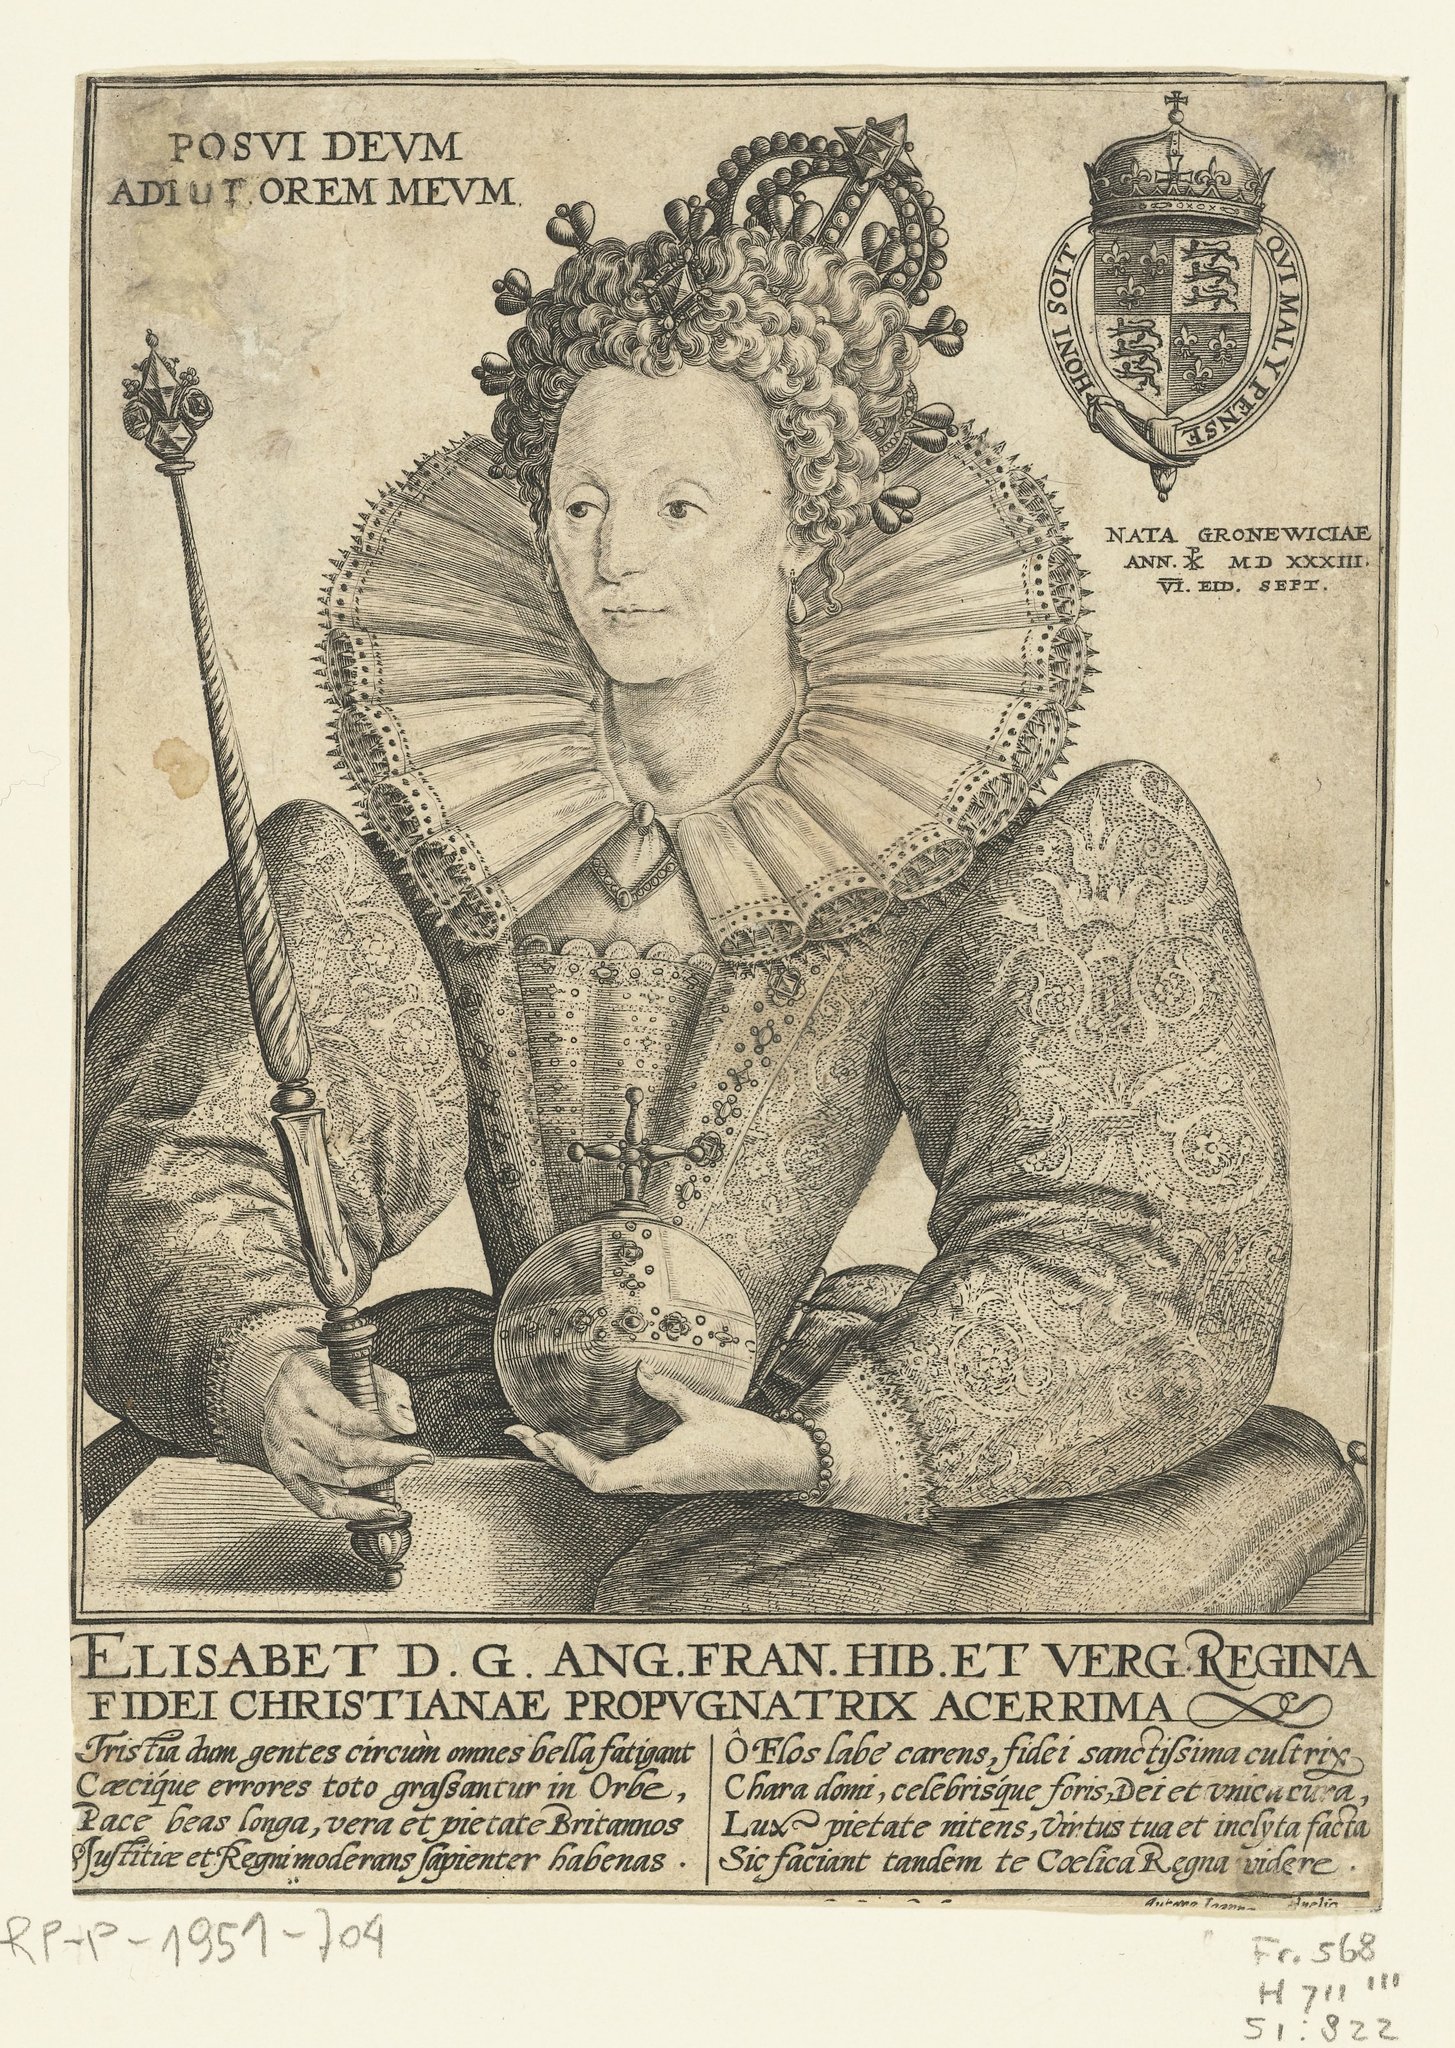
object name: print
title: Posvi Devm Adiut Orem Mevm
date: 1592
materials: paper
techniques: engraving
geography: cologne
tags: orb (symbol of sovereignty; sphere with cross on top), historical persons - bb - woman, sceptre, staff (symbol of sovereignty), queen, neck-gear: collar (+ women's clothes), dress, gown (+ women's clothes), lace, ear-rings, pearl; pearl necklace (+ women's clothes)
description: De japon heeft een brede los geplooide kraag* met kant, van voren open, met knoopsluiting. Kopmouwen* met trechtervormige manchetten* (ponjetten*), op dezelfde manier als de kraag afgezet met kant. Op het gekrulde haar een kroontje. Oorbellen*.